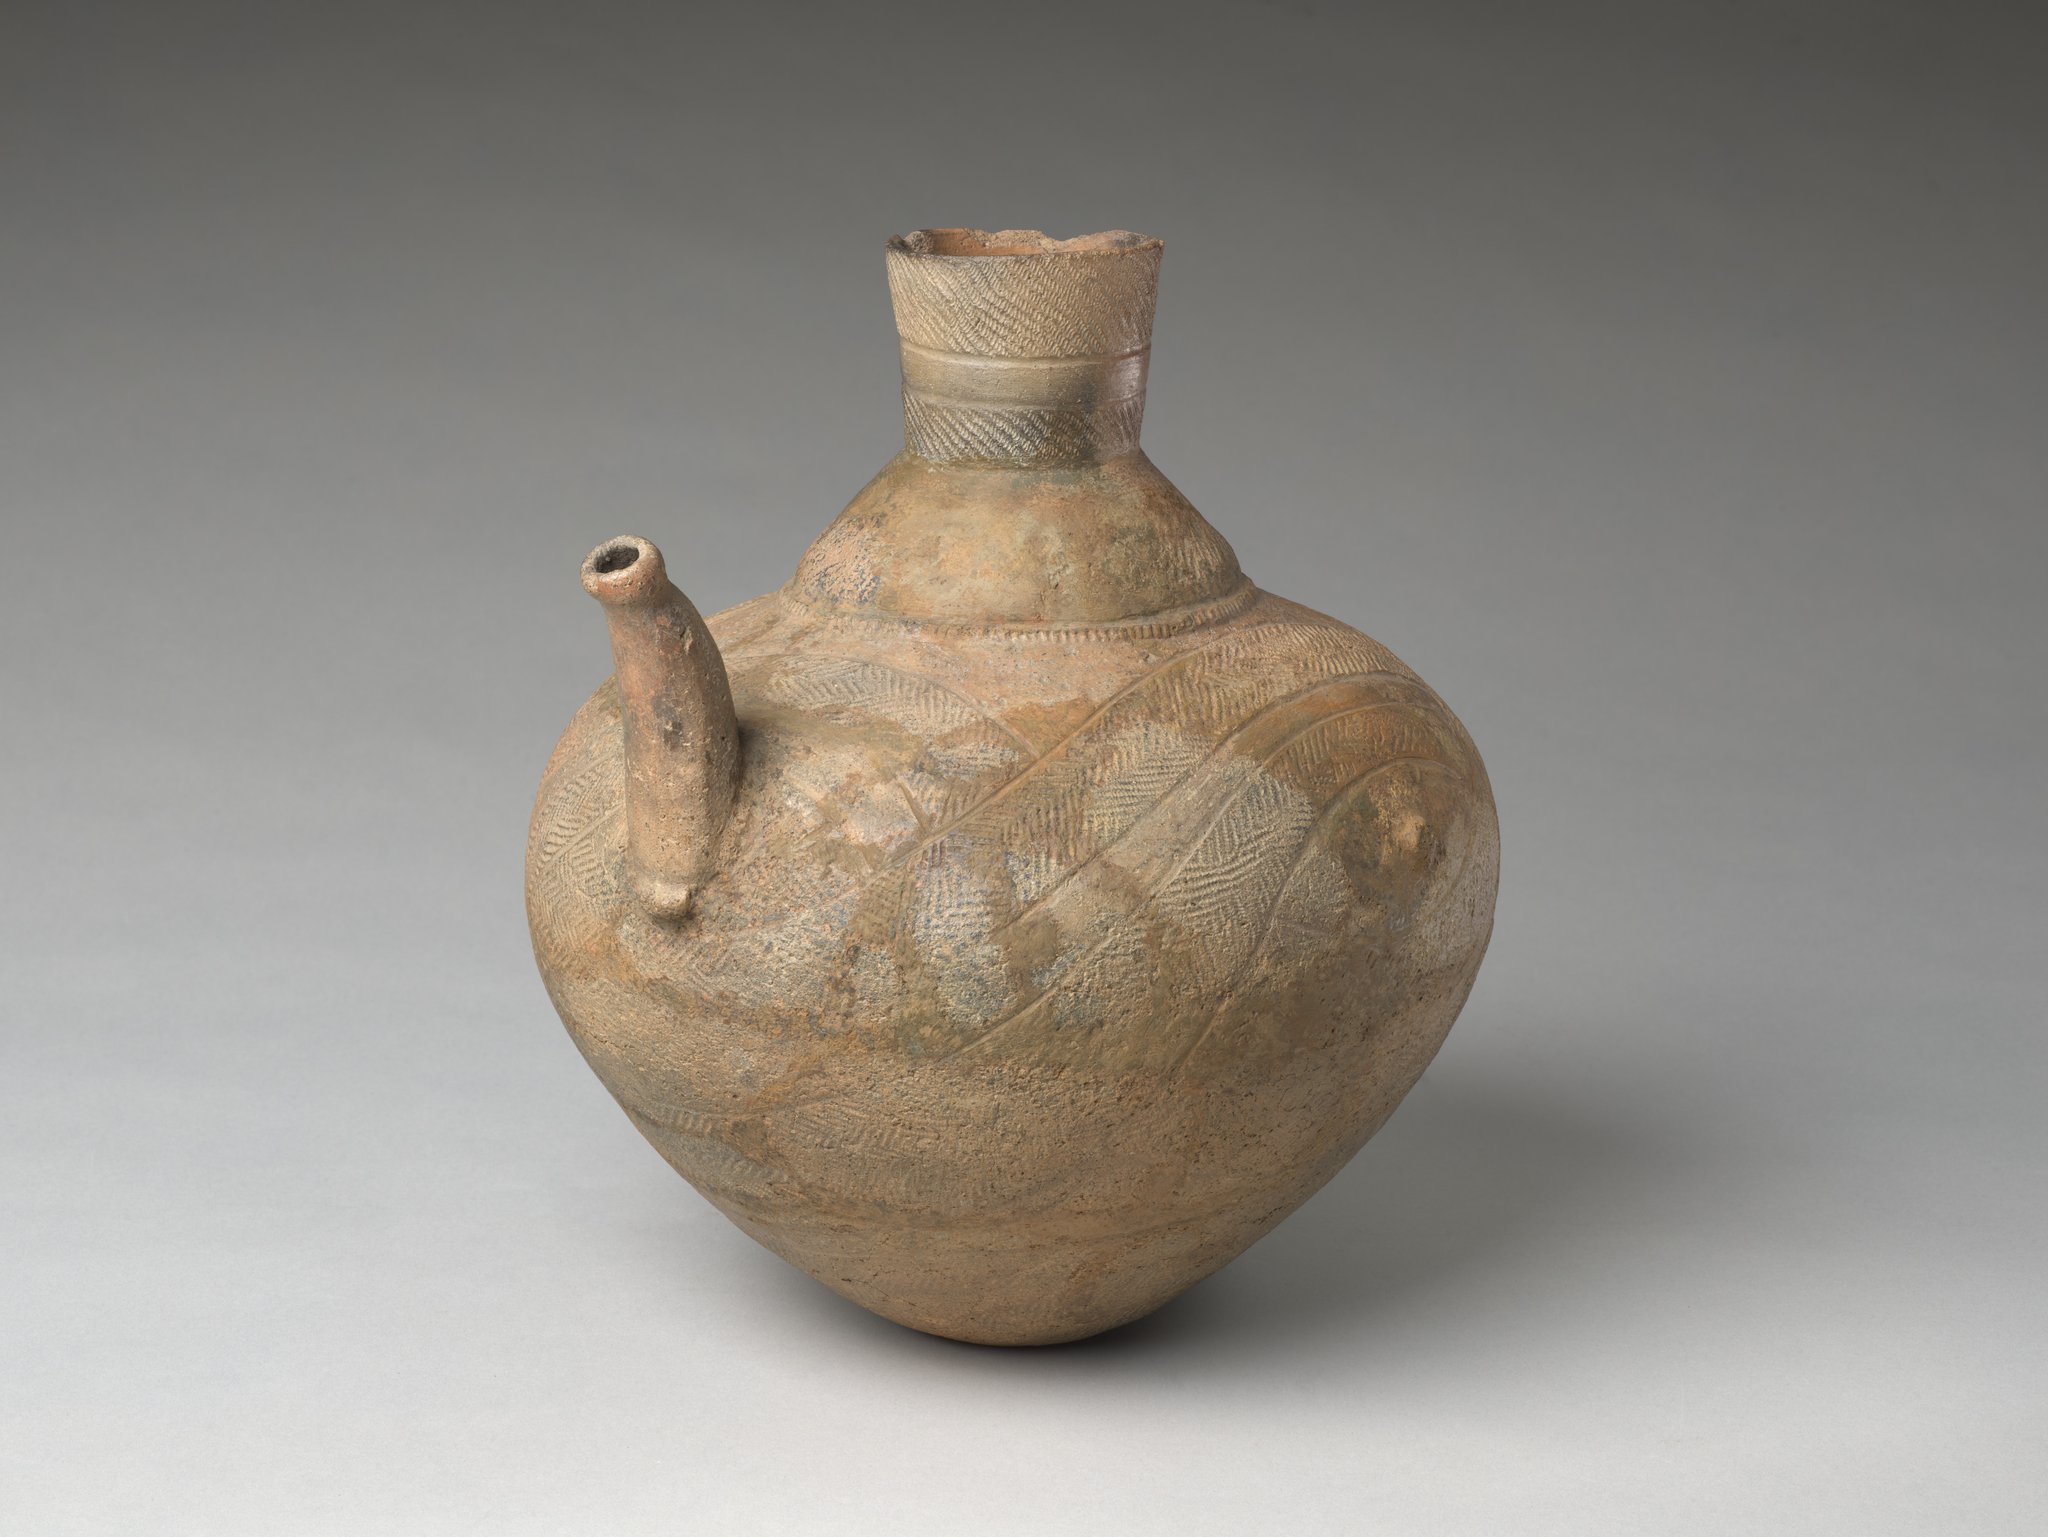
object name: vessel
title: Spouted Vessel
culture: japanese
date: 2500-1000 BCE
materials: cord, earthenware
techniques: incising